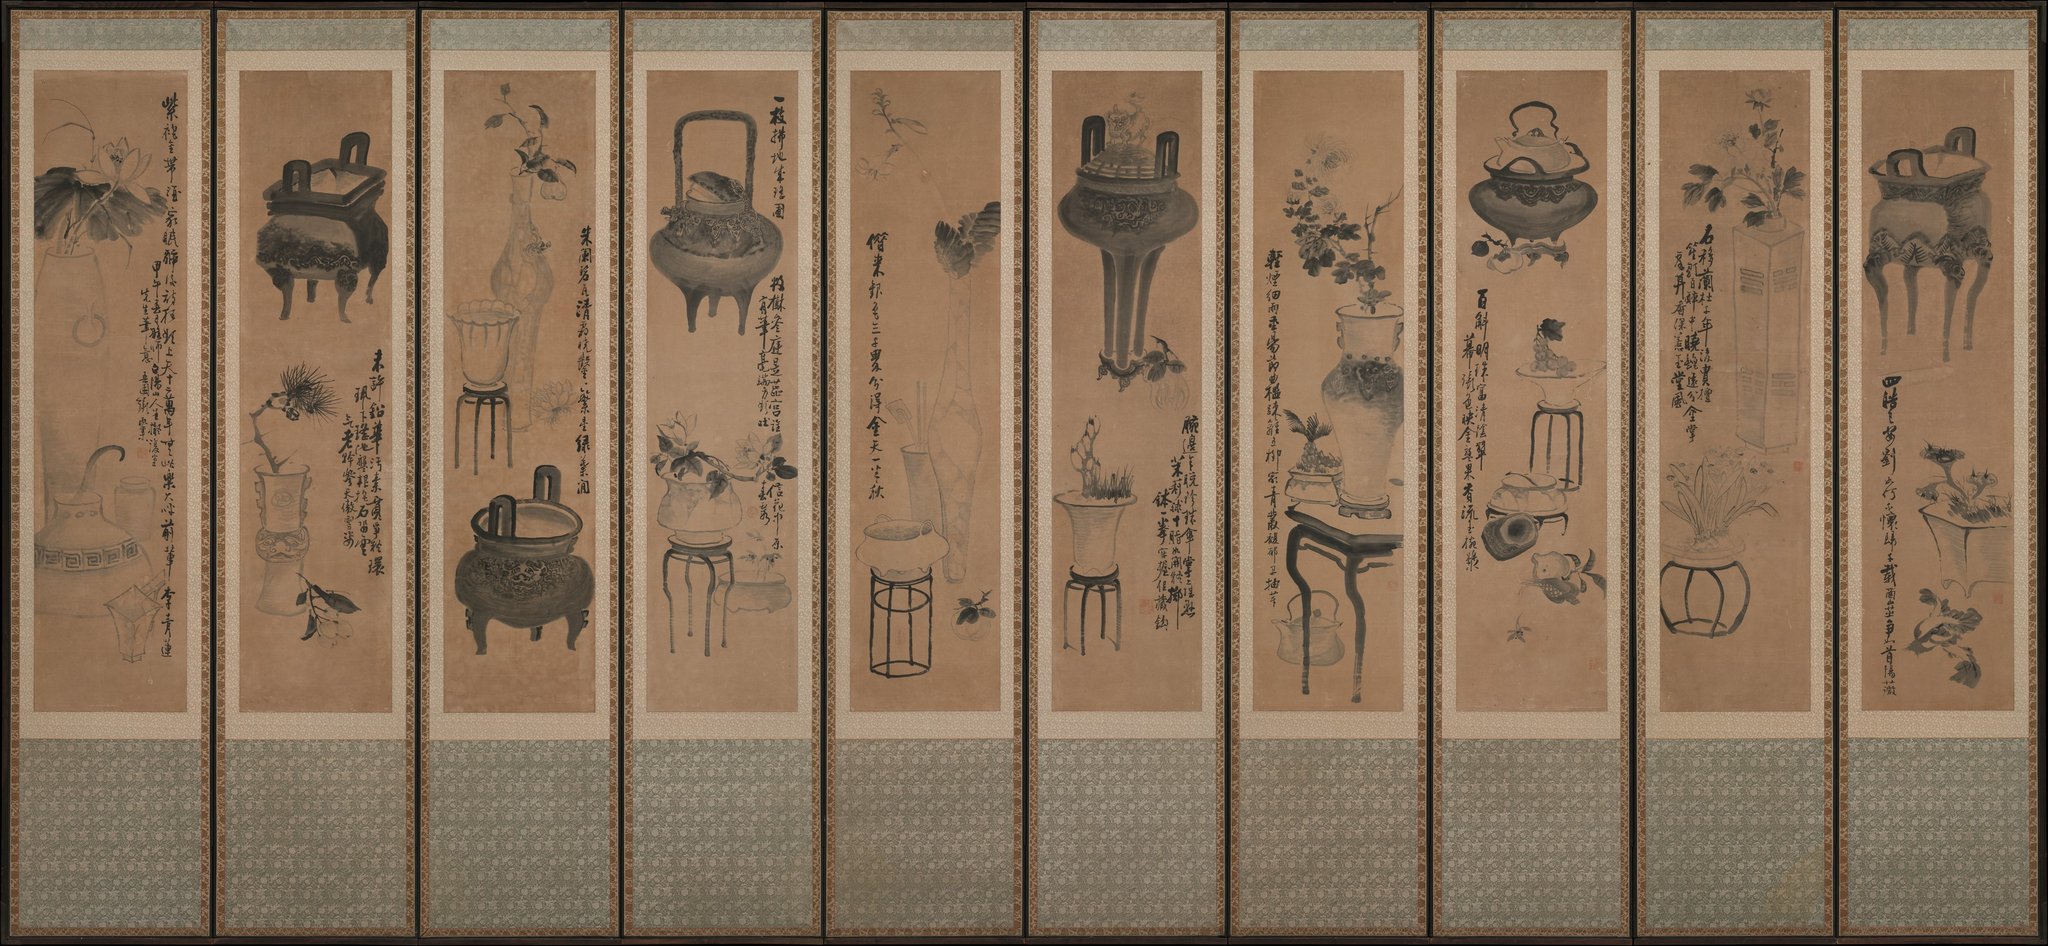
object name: screen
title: Still life with bronze vessels and flowering plants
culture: korean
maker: jang seung-eop (pen name: owon)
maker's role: artist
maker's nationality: korean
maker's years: 1843-1897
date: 1894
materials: ink, panel, paper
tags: plants,still life,vessels